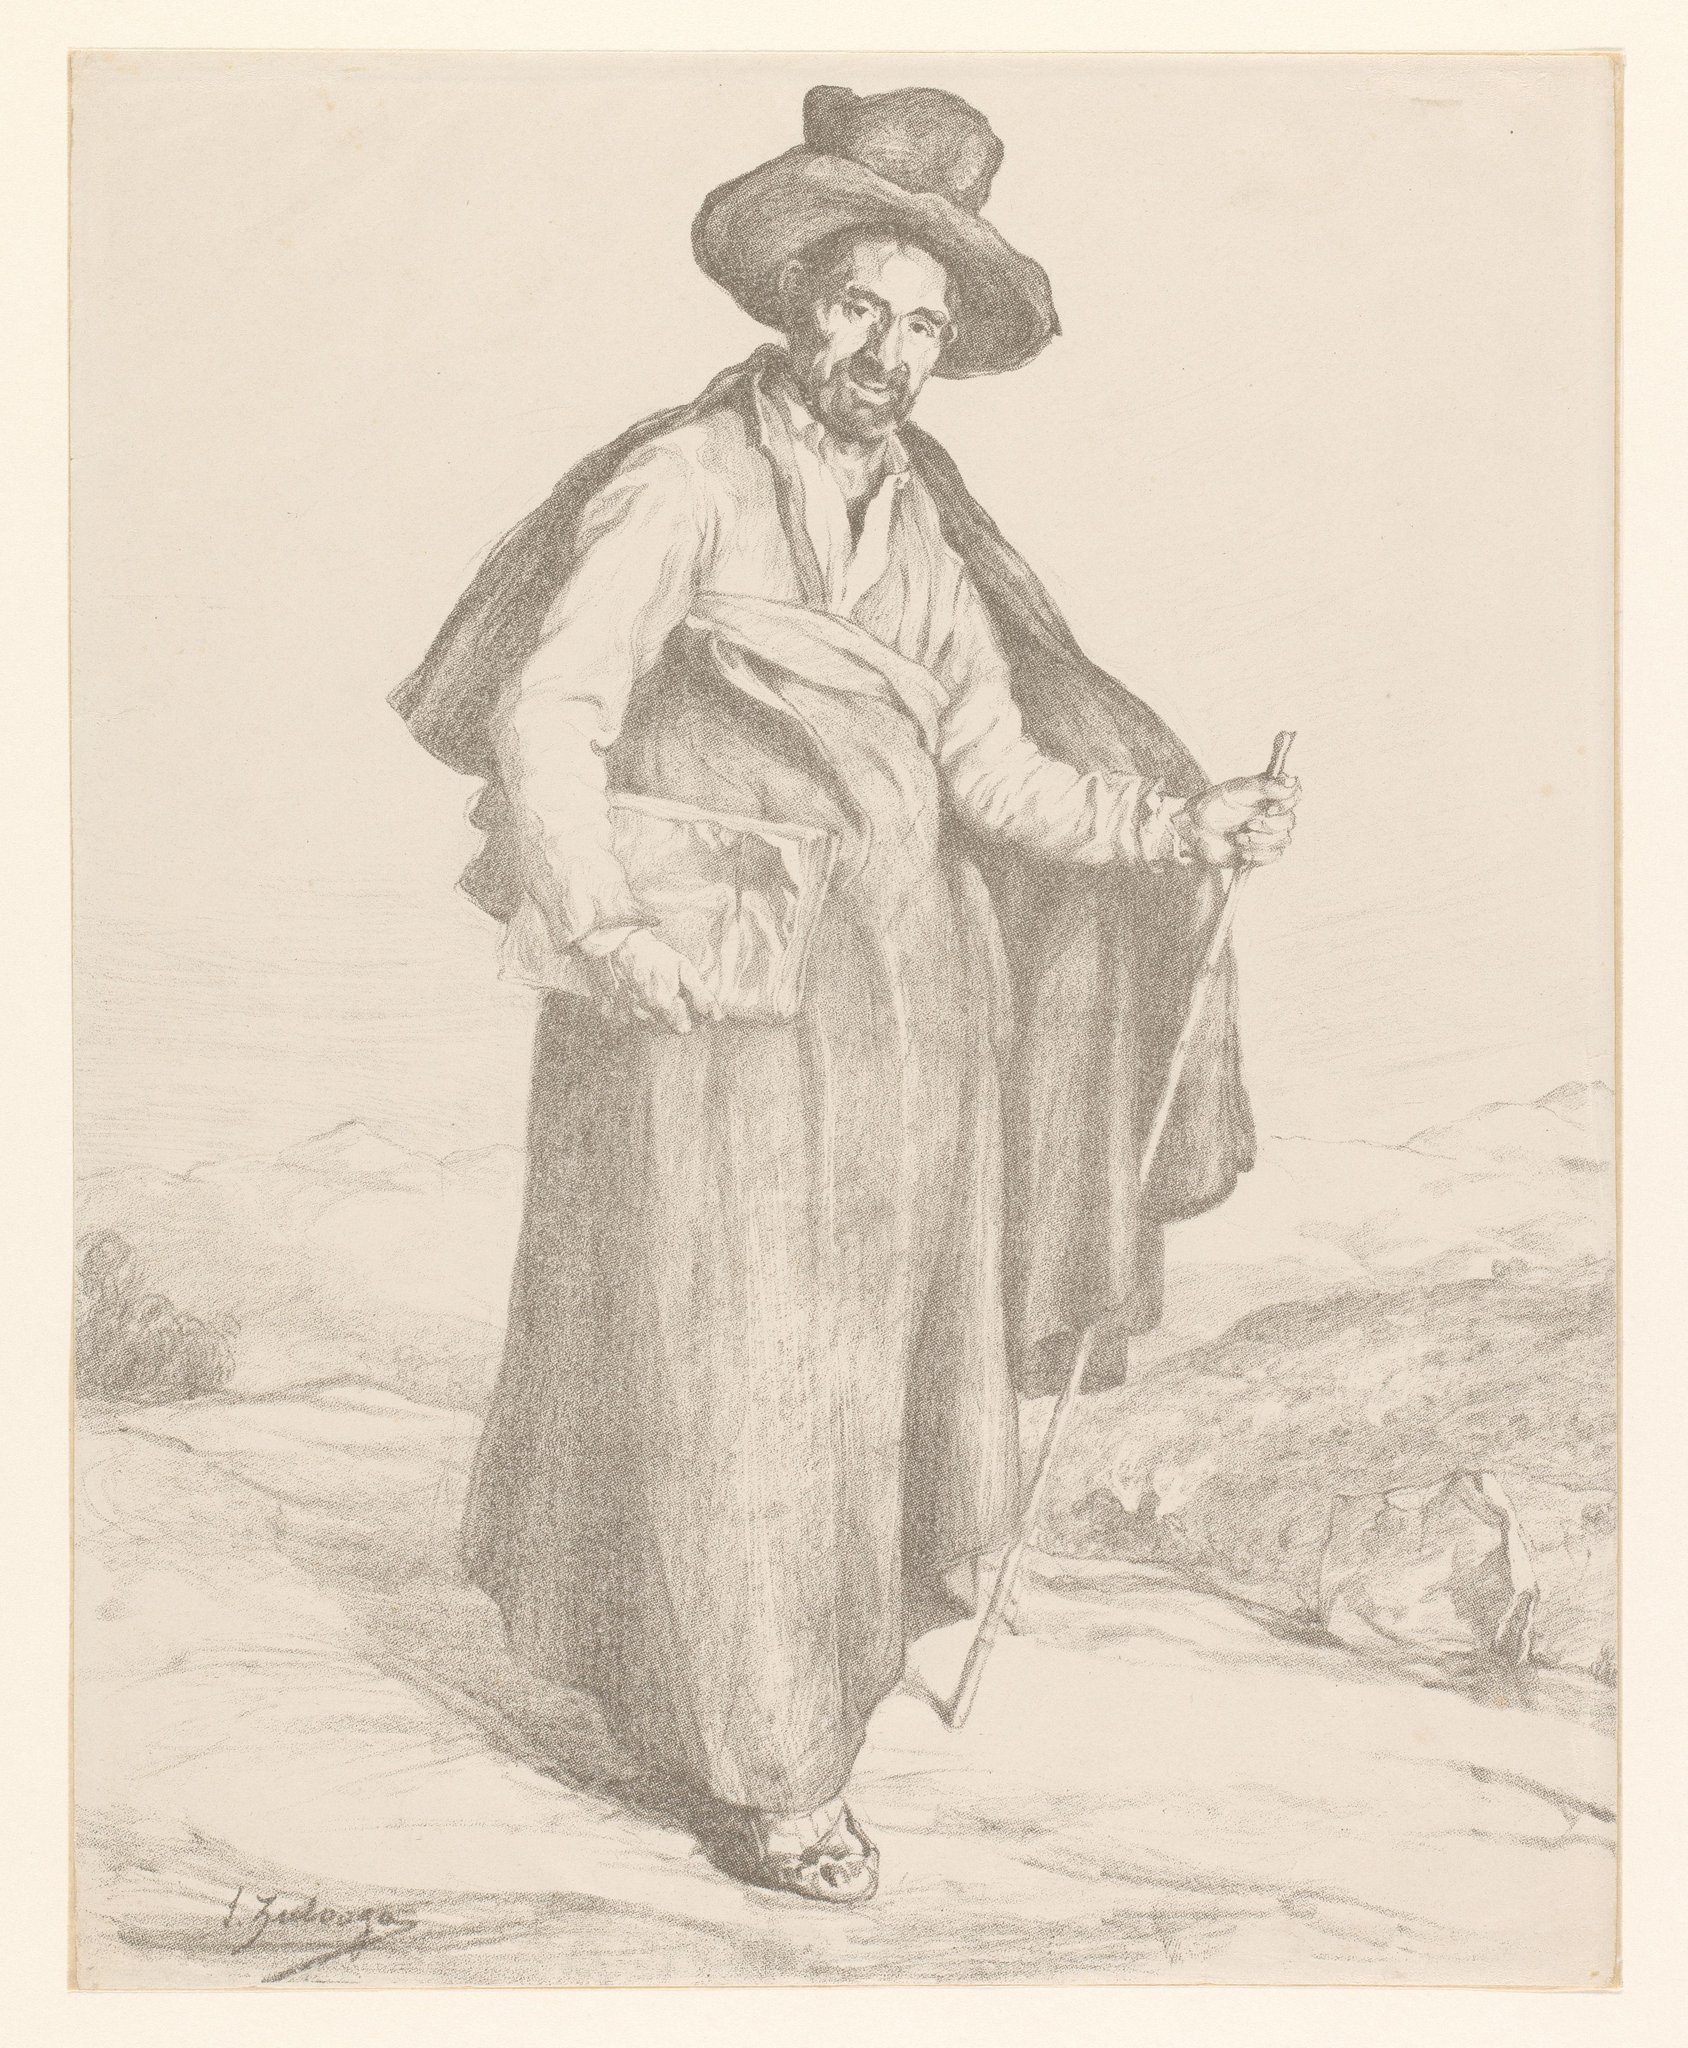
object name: print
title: Spaanse man met hoed en wandelstok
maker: ignacio zuloaga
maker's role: painter, print maker, sculptor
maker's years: 1870-1945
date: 1890-1945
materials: paper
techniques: lithograph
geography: spain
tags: adult man, 'en route', traveller under way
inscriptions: signature: ‘I. Zuloaga’, collector's mark: Lugt 2861a, collector's mark: Lugt 2228